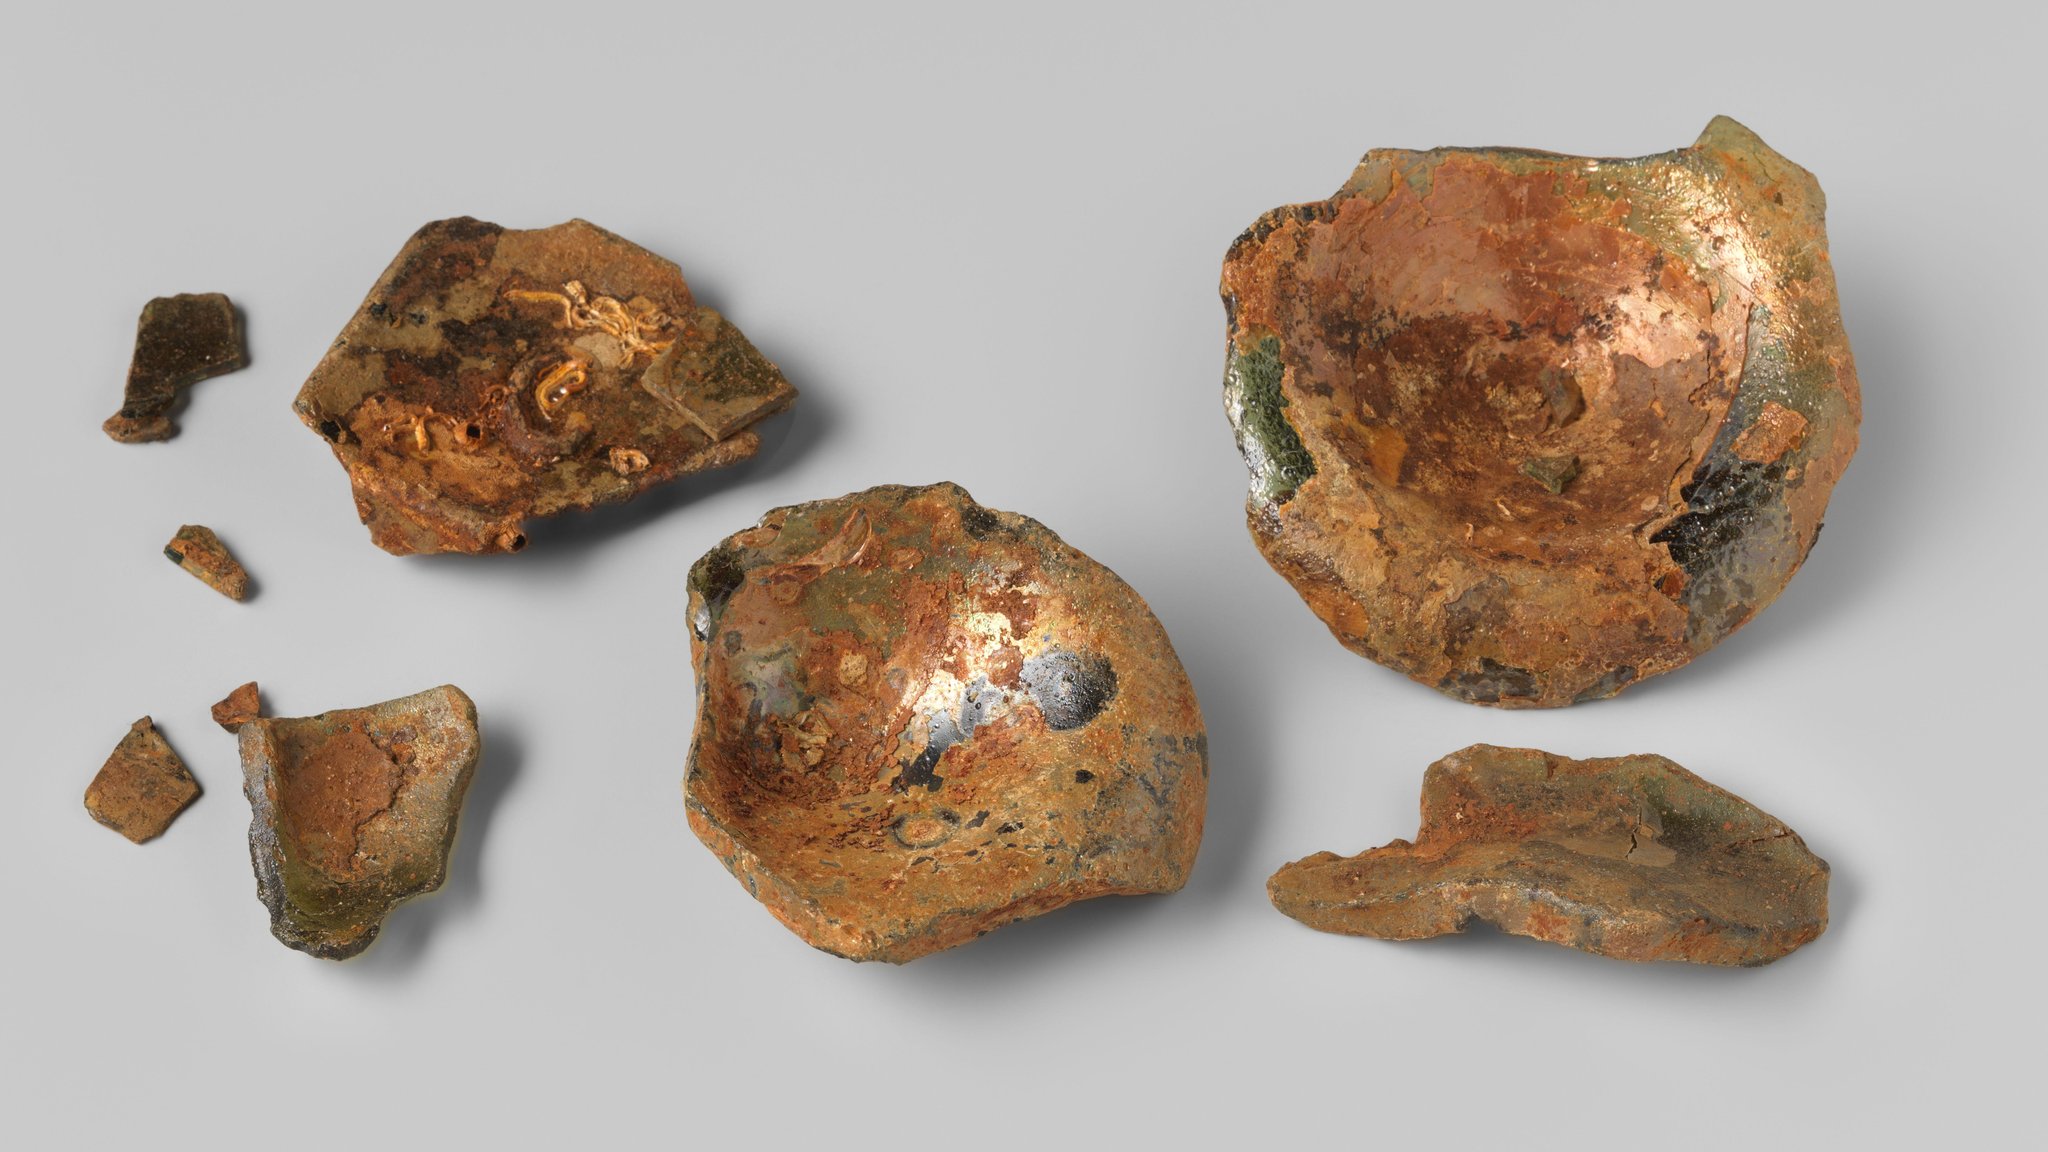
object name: wine bottle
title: Scherven van wijnflessen uit het wrak van de Oostindiëvaarder Hollandia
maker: Anonymous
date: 1700-1743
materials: glass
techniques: green glass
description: Scherven van wijnflessen, onder andere bodemfragmenten.